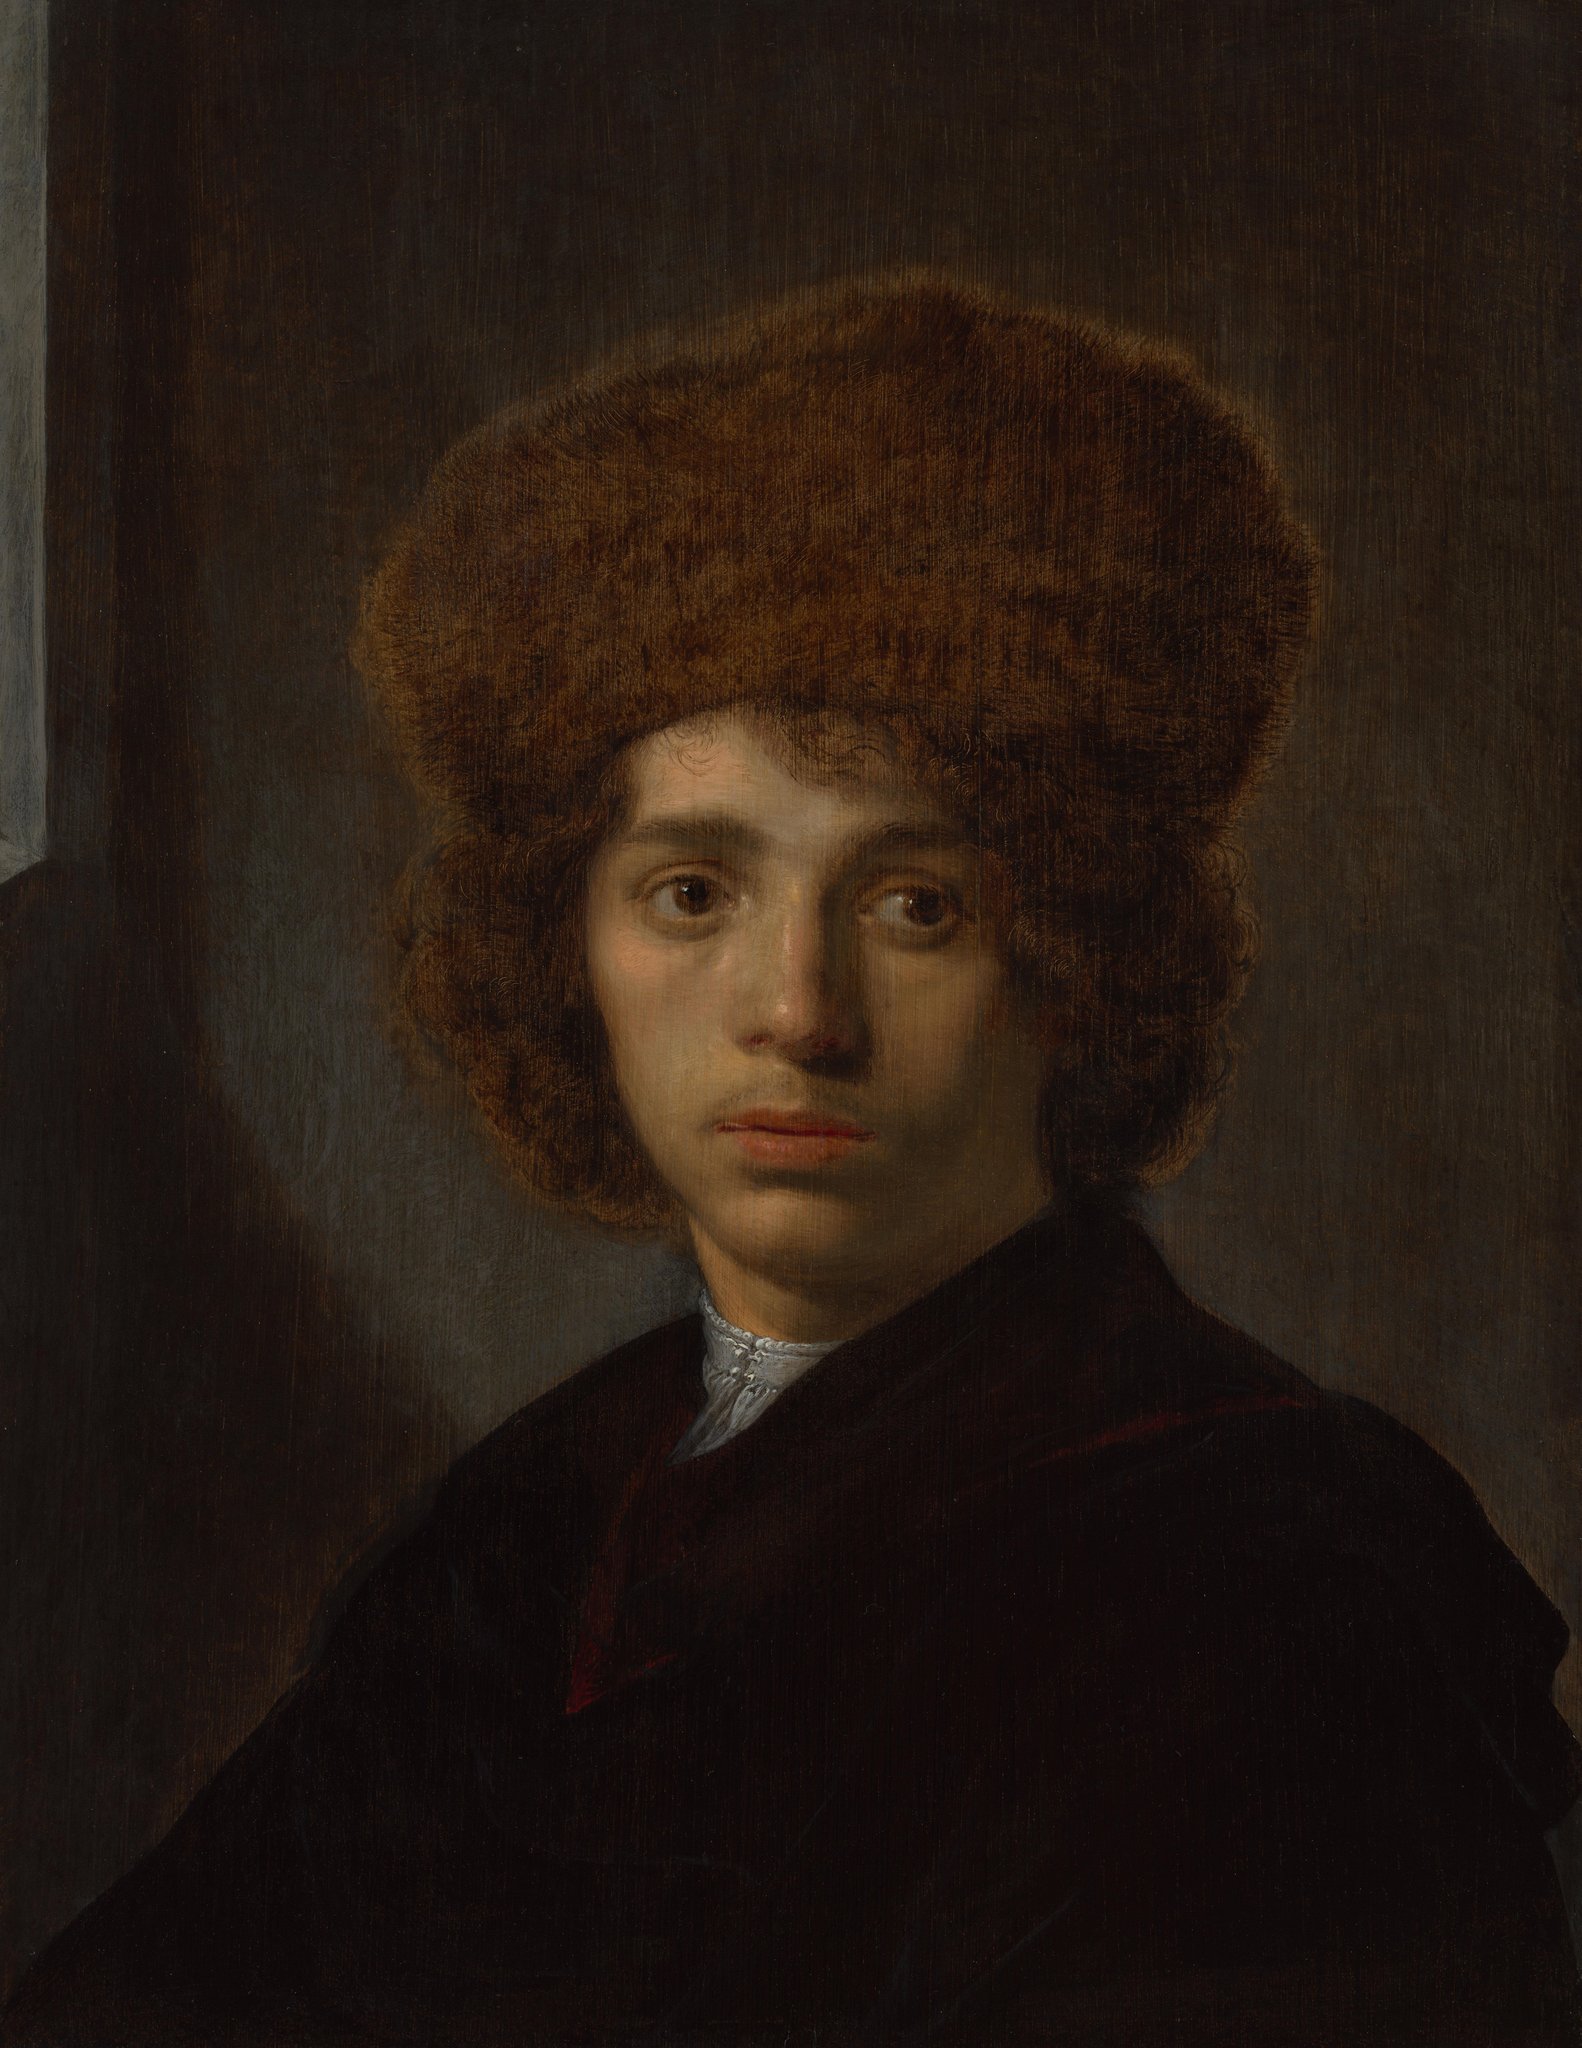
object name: painting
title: Young Man with a Fur Hat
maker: david bailly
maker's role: draughtsman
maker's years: 1584-1657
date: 1635-1640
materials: oil, panel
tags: head-gear (with name), historical persons not known by name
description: Portret van een jonge man met een bontmuts. Buste.